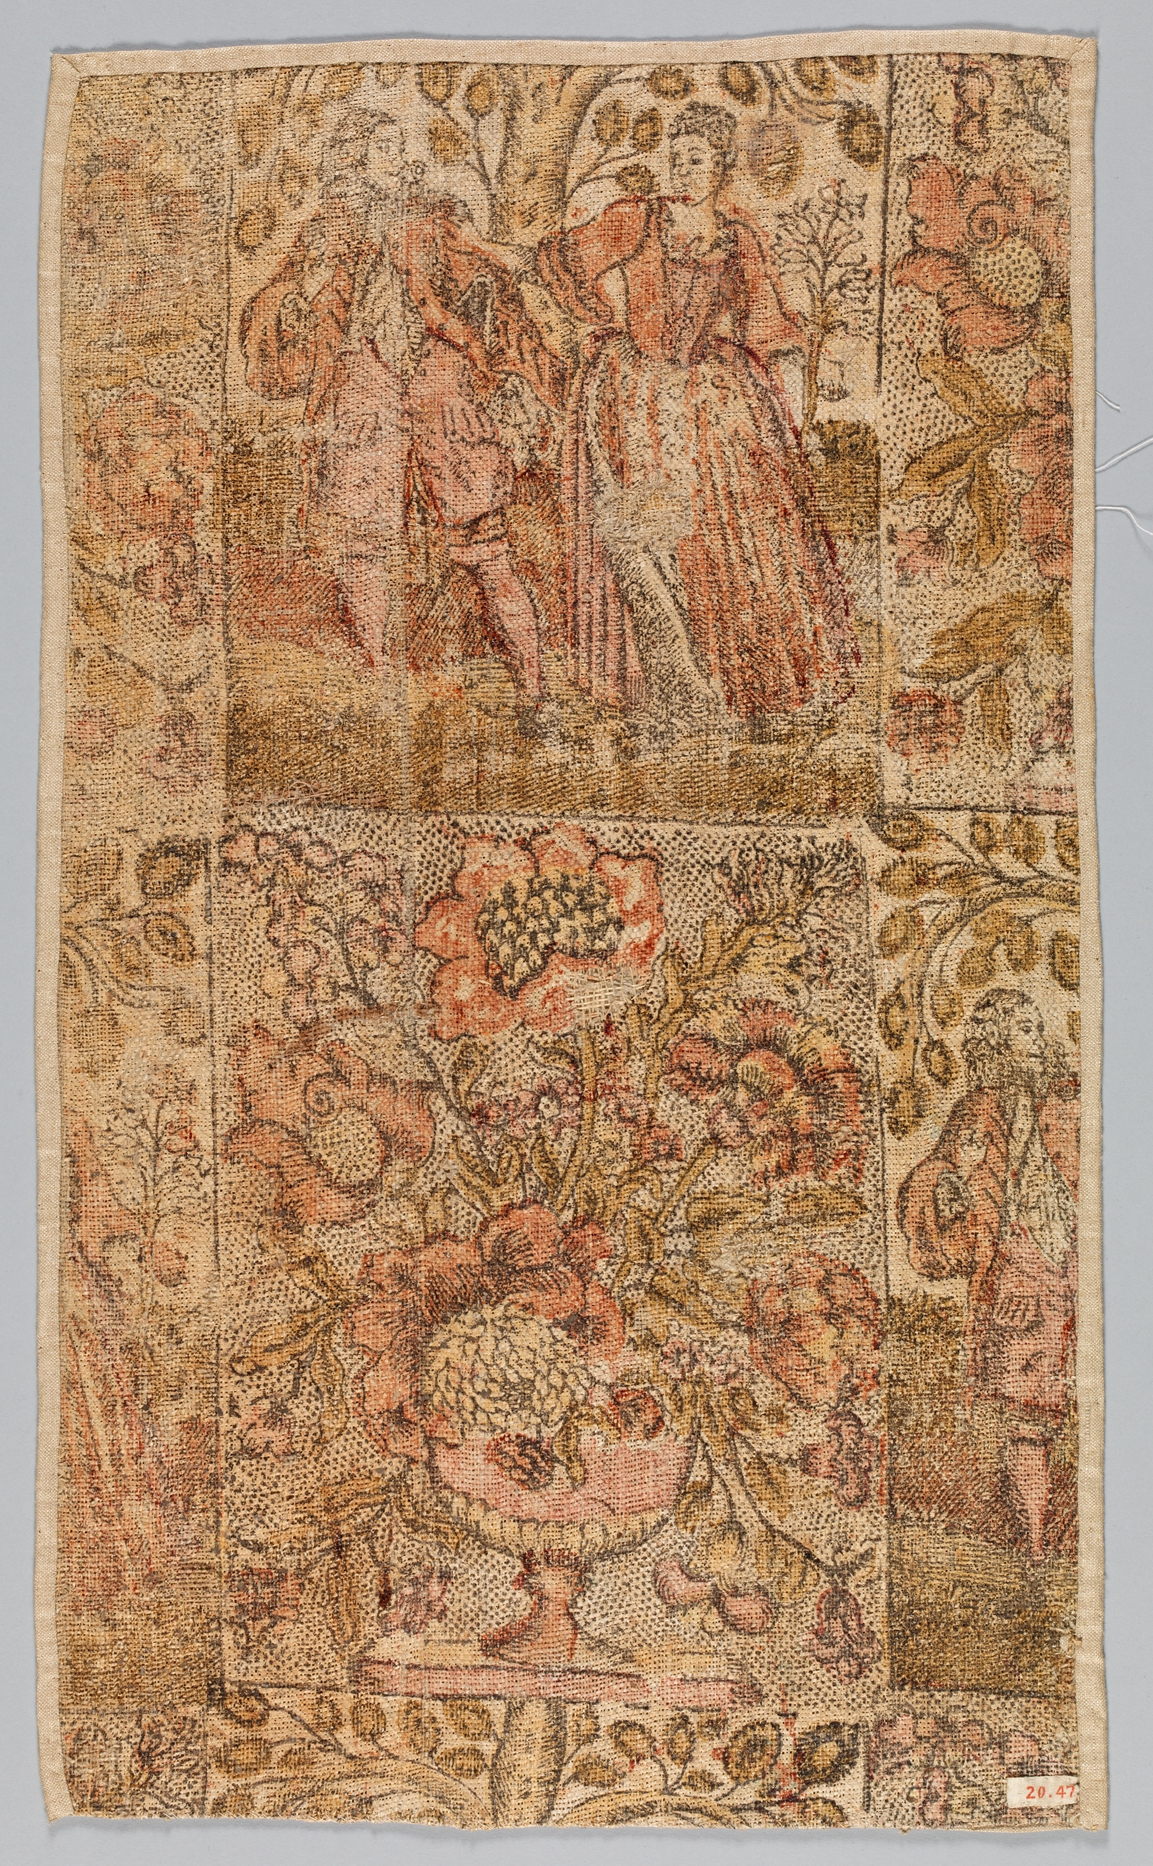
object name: piece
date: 1701-1733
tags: men,women,flowers,leaves